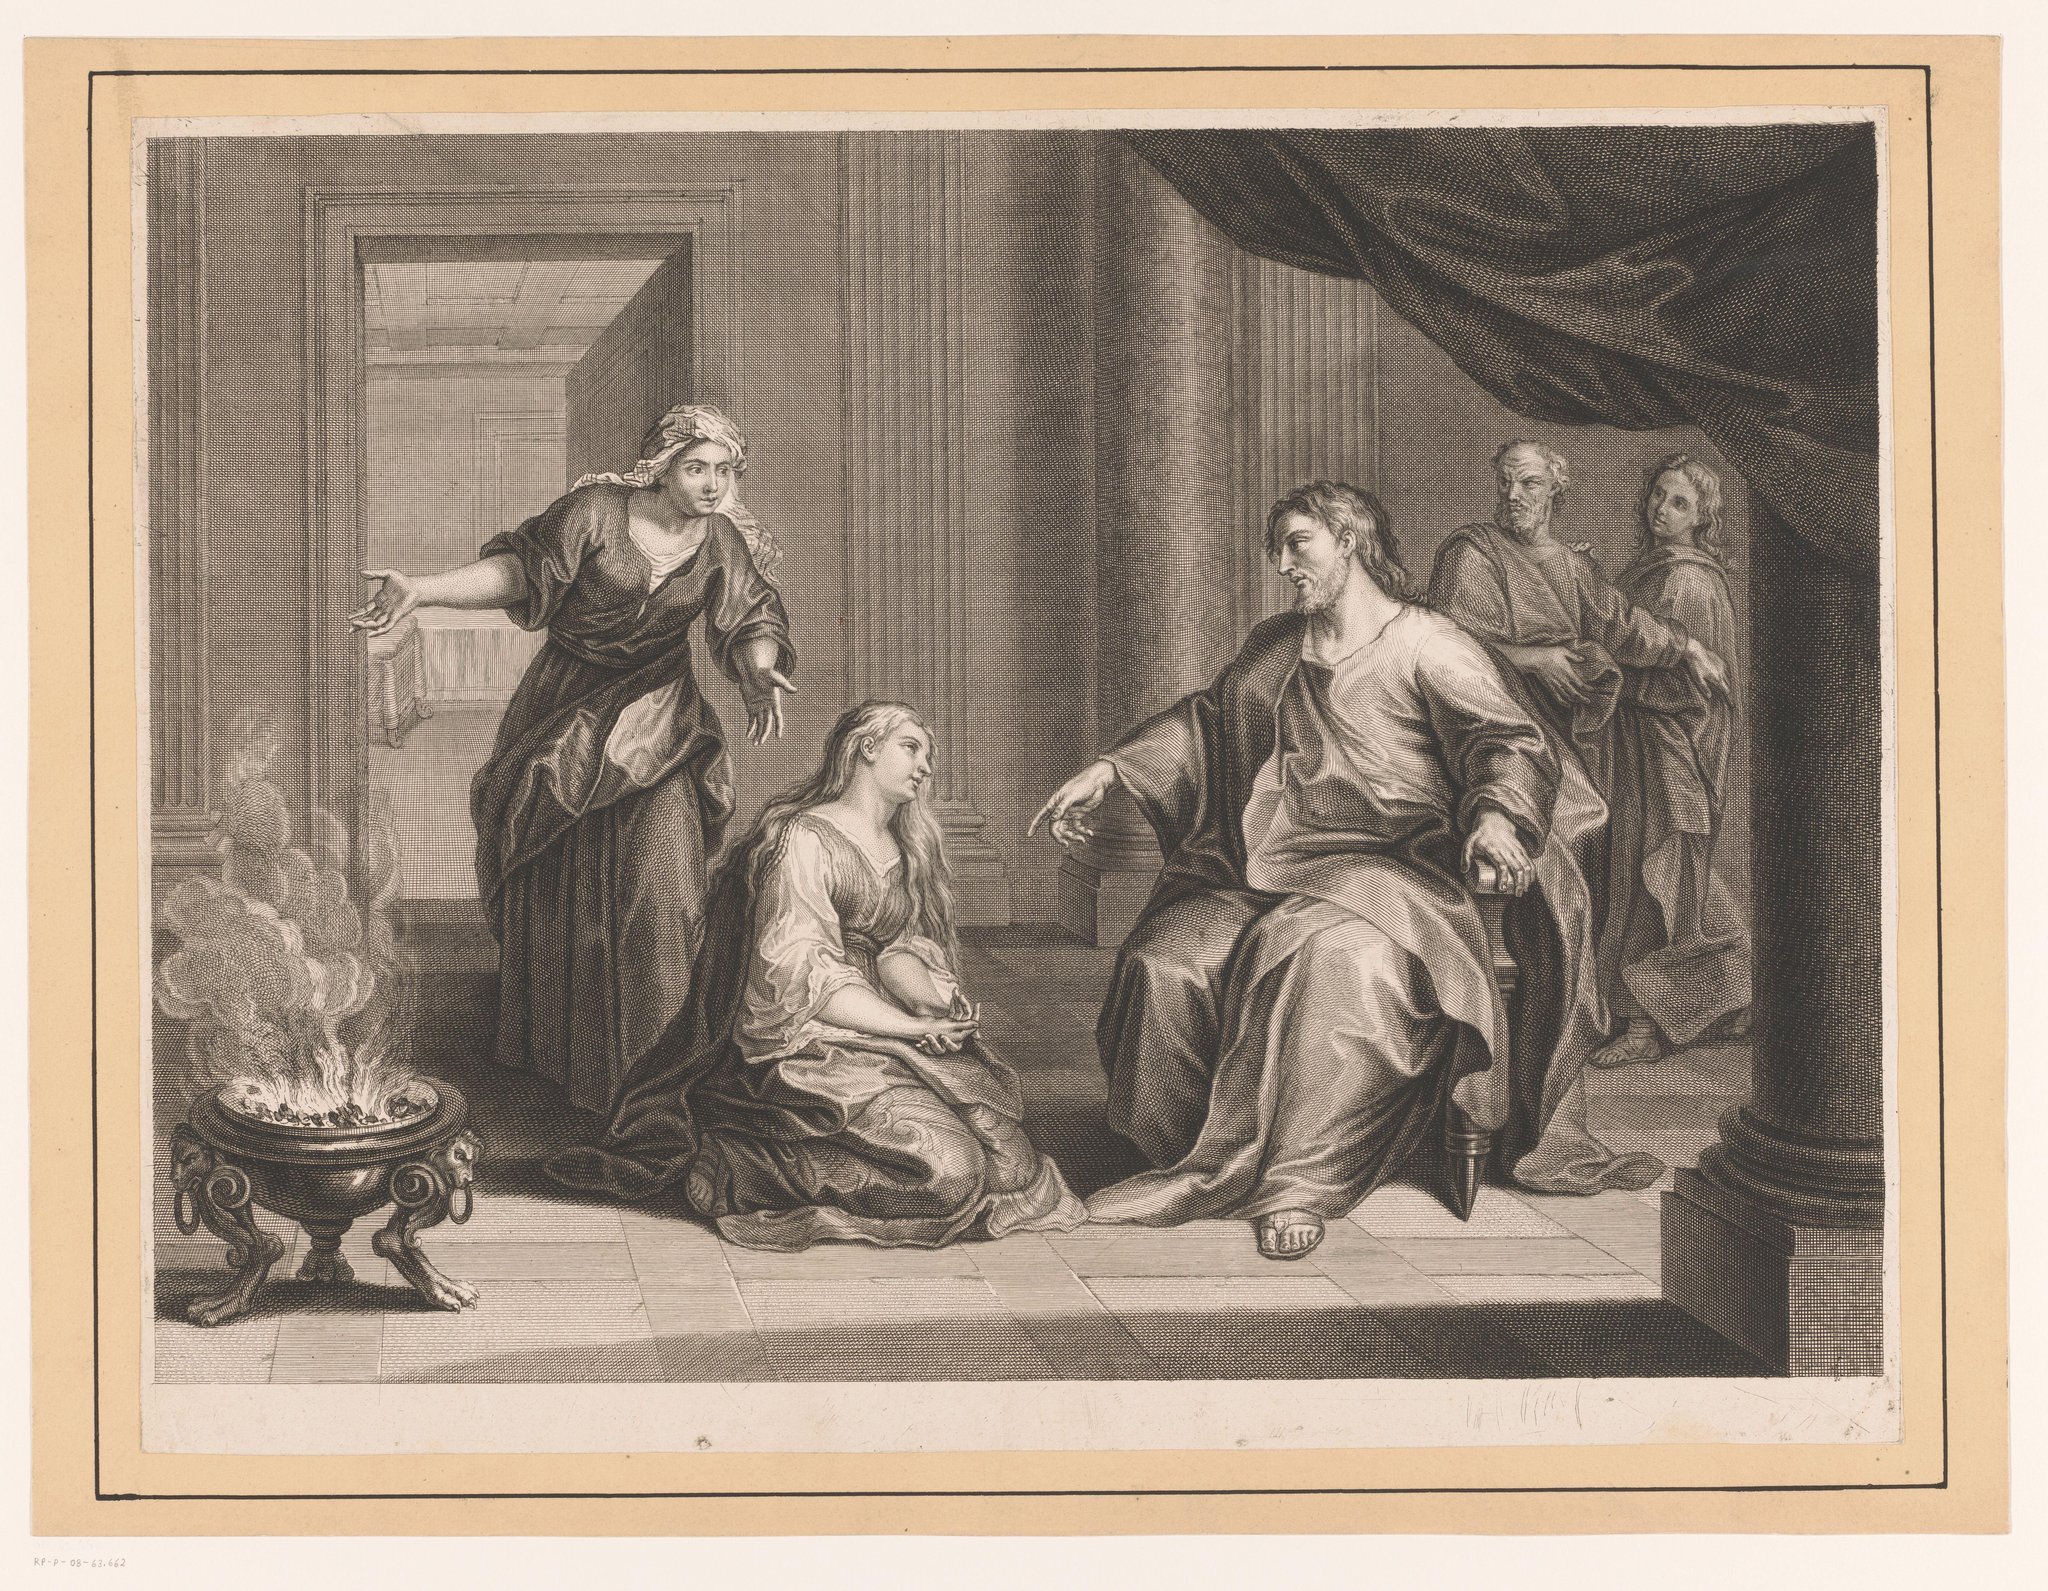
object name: print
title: Christus in het huis van Martha en Maria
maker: Anonymous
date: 1600-1699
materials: paper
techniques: engraving, etching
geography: france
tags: christ in the house of martha and mary (luke 10:38-42)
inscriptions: collector's mark: Lugt 2233